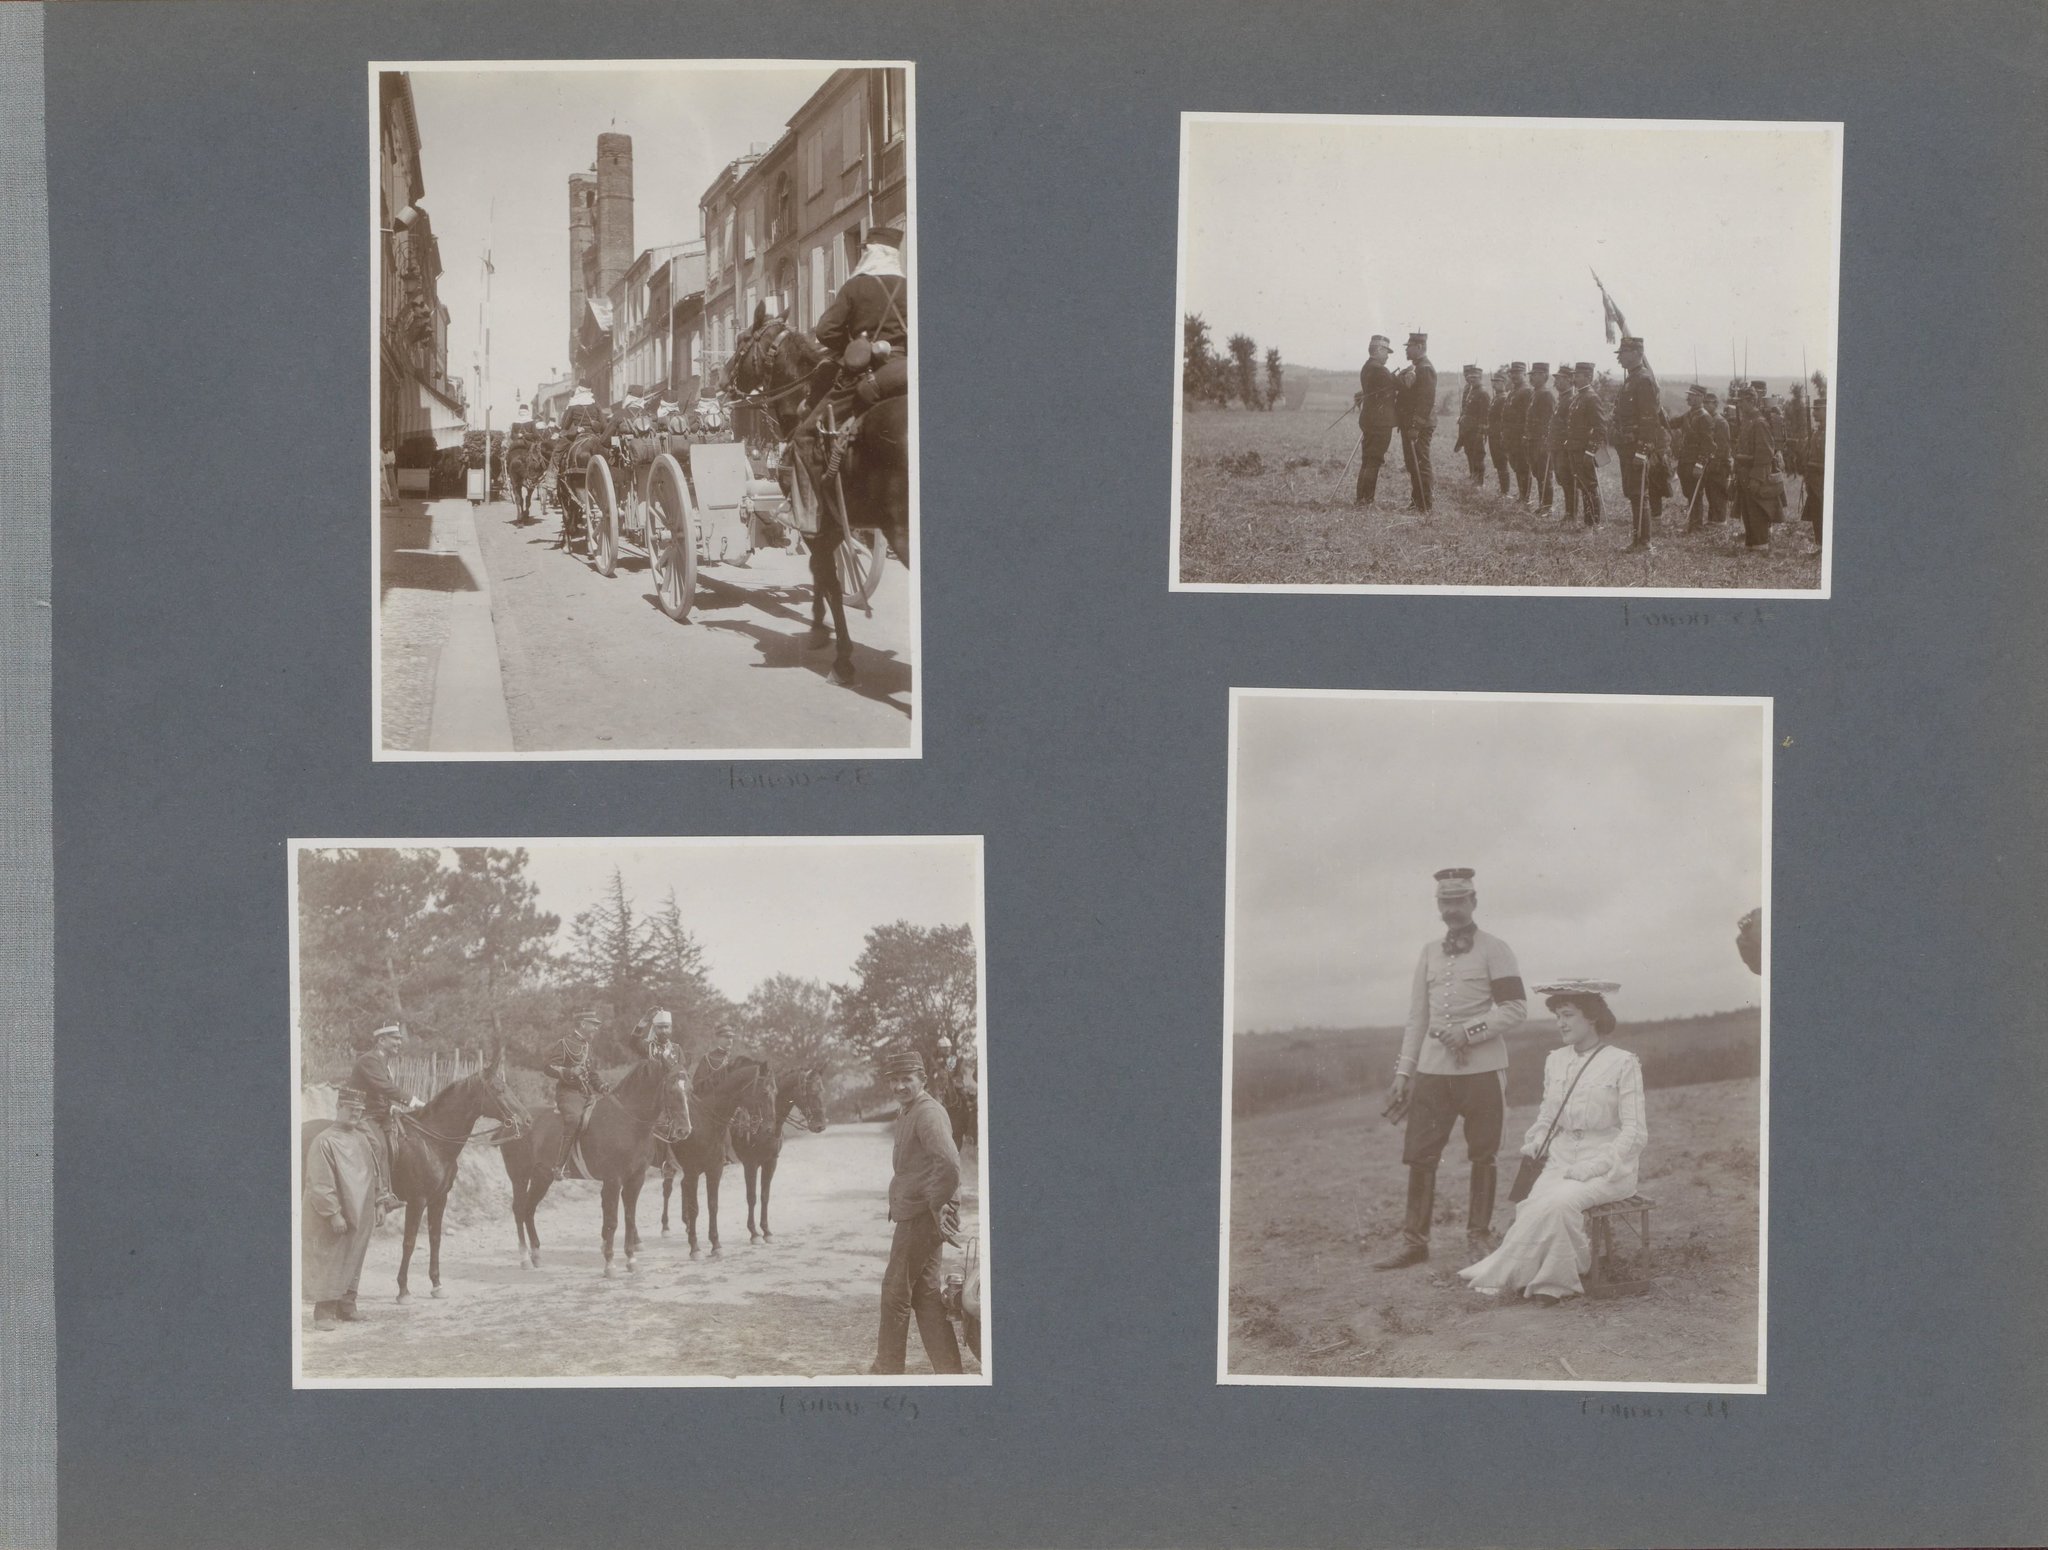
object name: photograph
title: Militair wordt gedecoreerd in een veld in Frankrijk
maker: Anonymous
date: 1902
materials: paper, photographic support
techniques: daylight paper print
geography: france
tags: manoeuvre ~ military training, military honours, land forces, france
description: Onderdeel van Fotoalbum van een legeroefening in Zuidwest-Frankrijk in 1902.